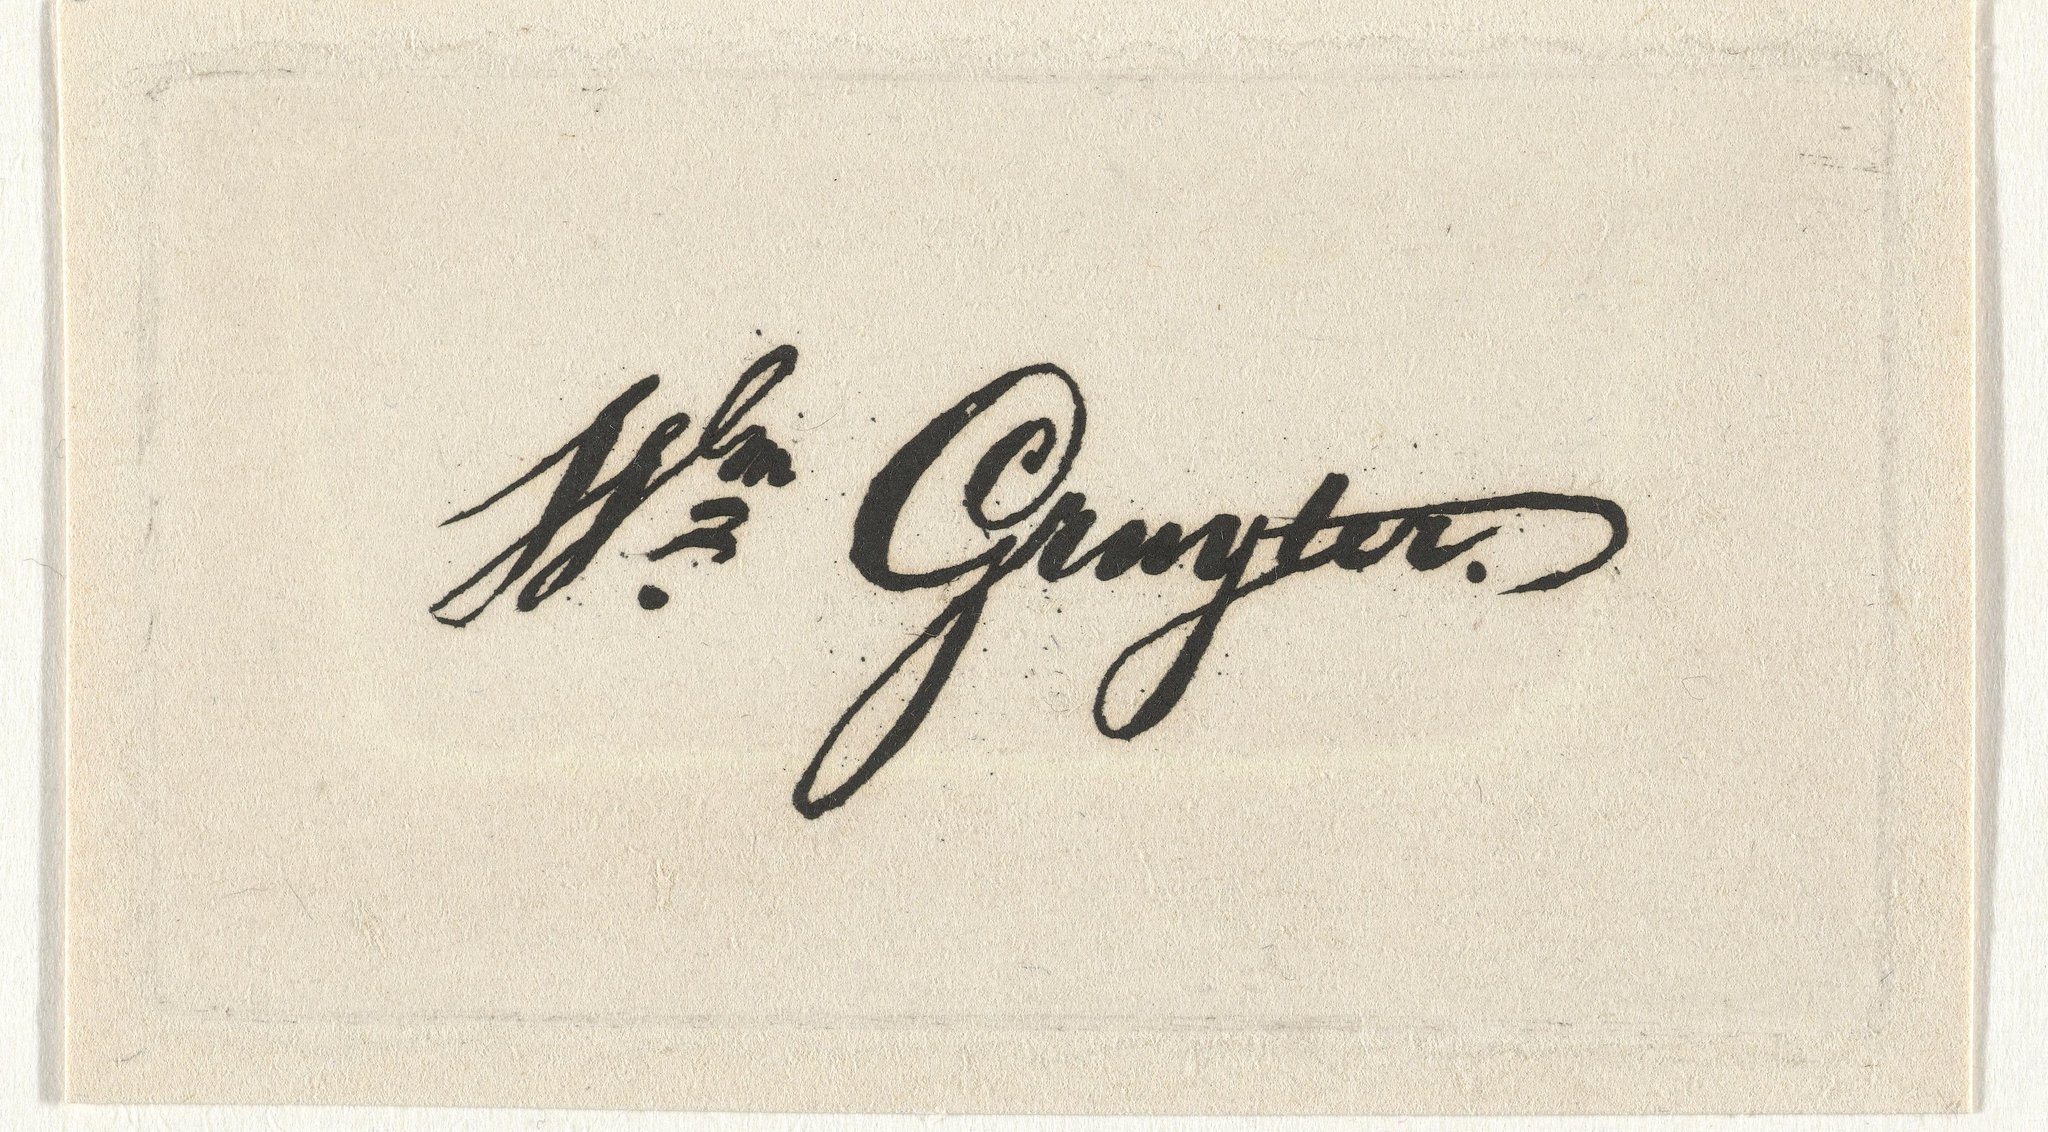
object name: print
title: Signatuur van Willem Gruyter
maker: willem gruyter jr.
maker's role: draughtsman, print maker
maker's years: 1817-1880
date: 1832-1880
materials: paper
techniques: etching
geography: amsterdam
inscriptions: collector's mark: Lugt 2228